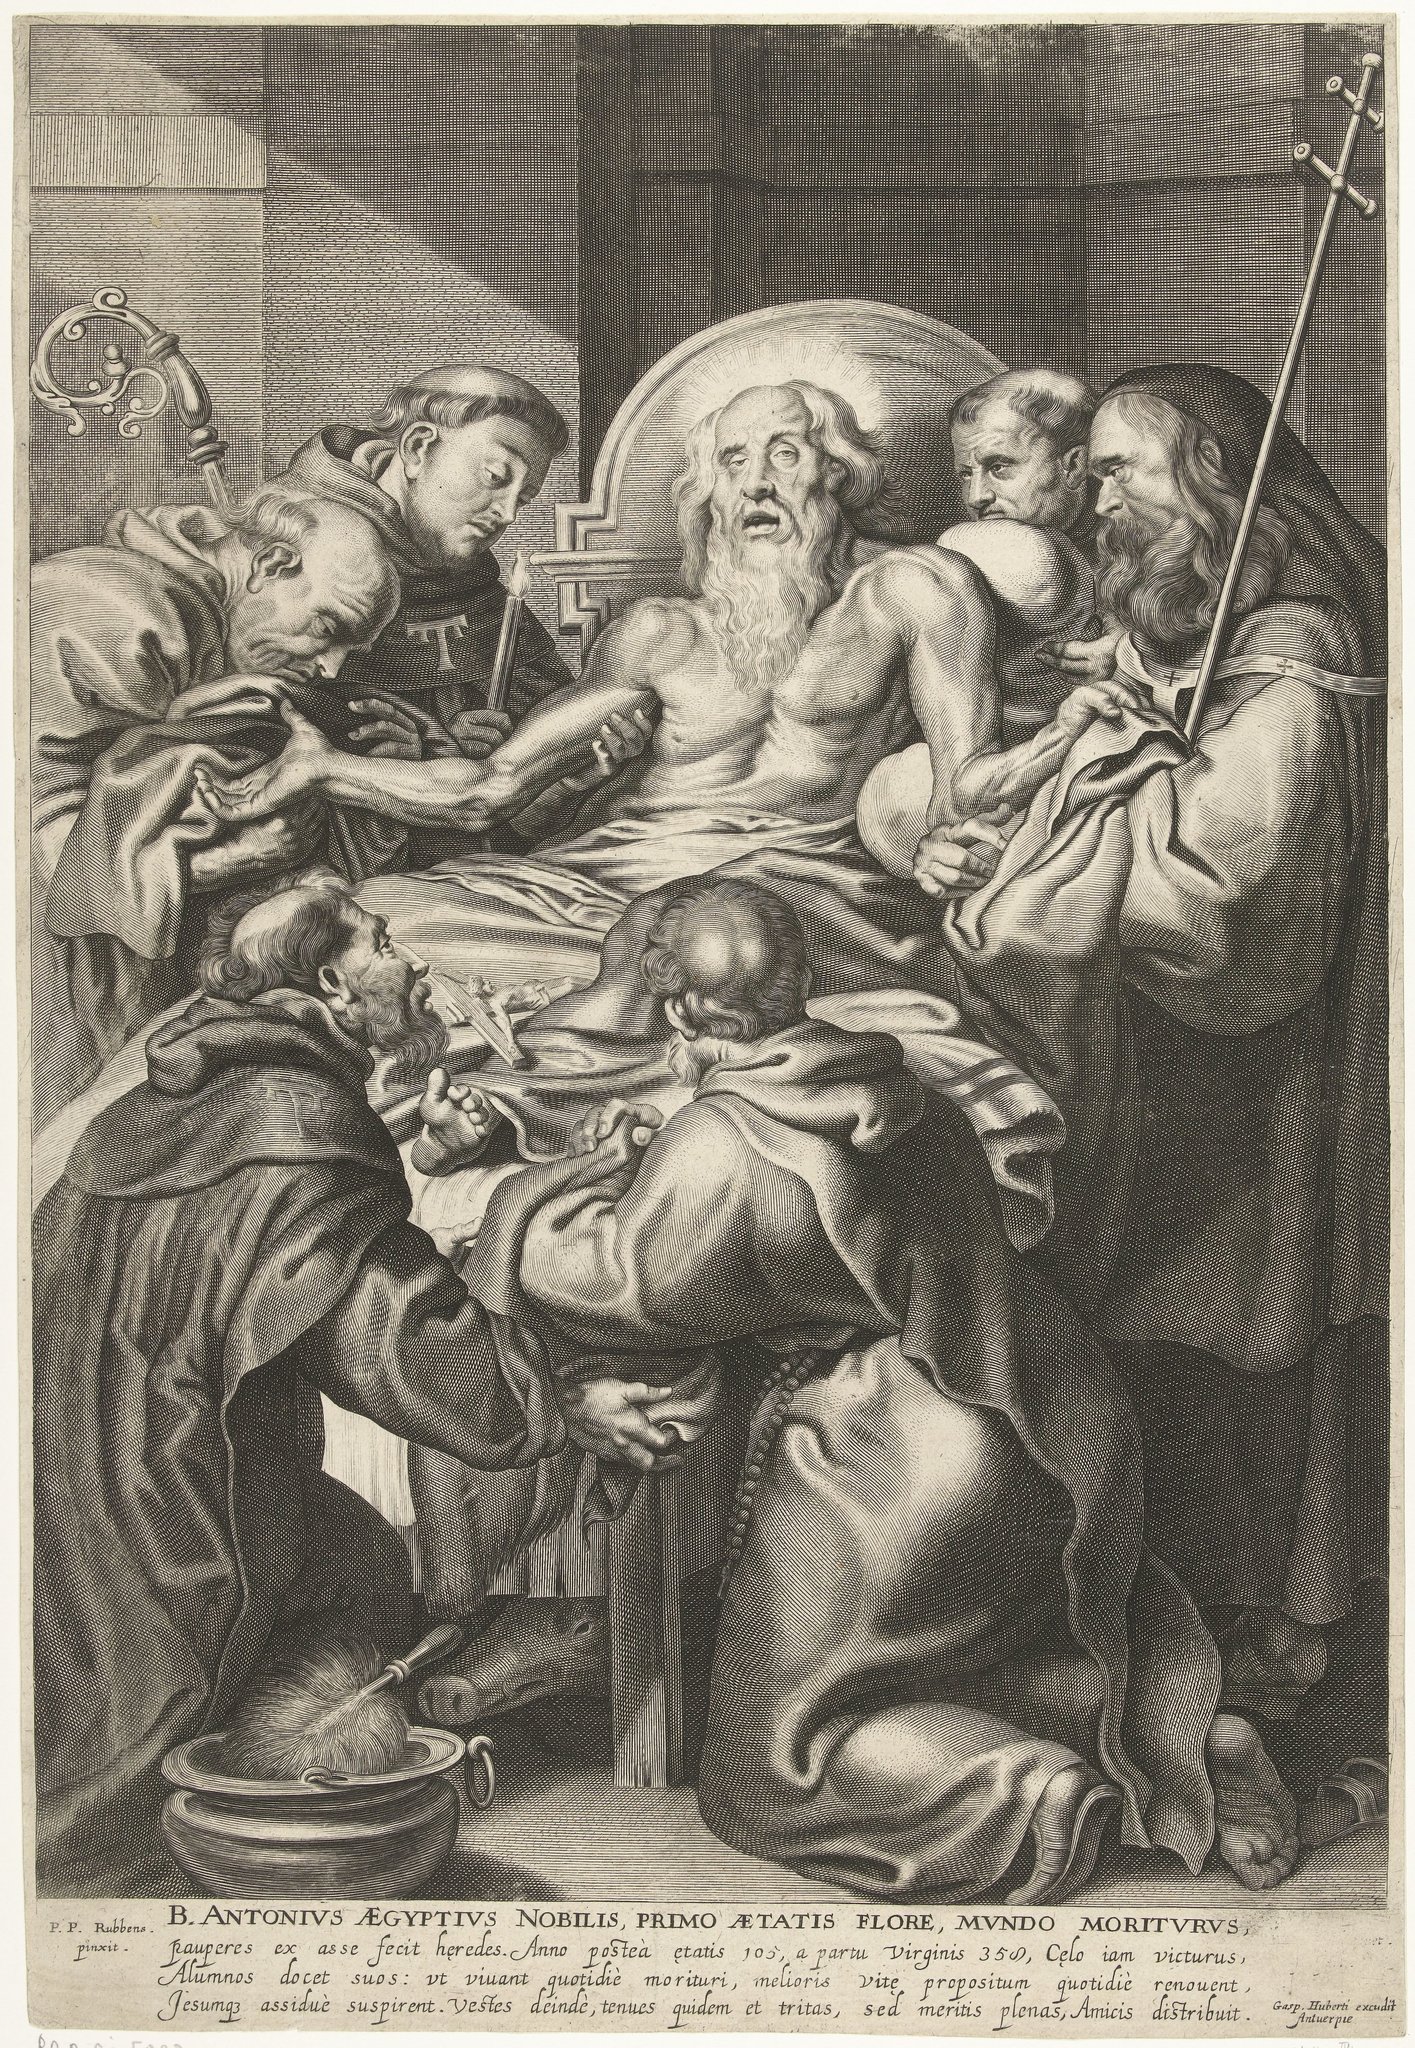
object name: print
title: Sterfbed van de Heilige Antonius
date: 1649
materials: paper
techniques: engraving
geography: antwerp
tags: the hermit antony abbot (antonius abbas) of egypt, also called the great; possible attributes: bell, book, t-shaped staff, flames, pig - death, deathbed of male saint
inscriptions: collector's mark: Lugt 240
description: De Heilige Anthonius op zijn sterbed. Zijn discipels staan rondom het bed en bidden voor zijn welzijn. De Heilige Anthonius geeft een van zijn schaapshuiden aan de Heilige Athanasius, de andere schaapshuid krijgt de Heilige Serapion. Onder het bed het varken van de Heilige Anthonius. De prent heeft een Latijns onderschrift.